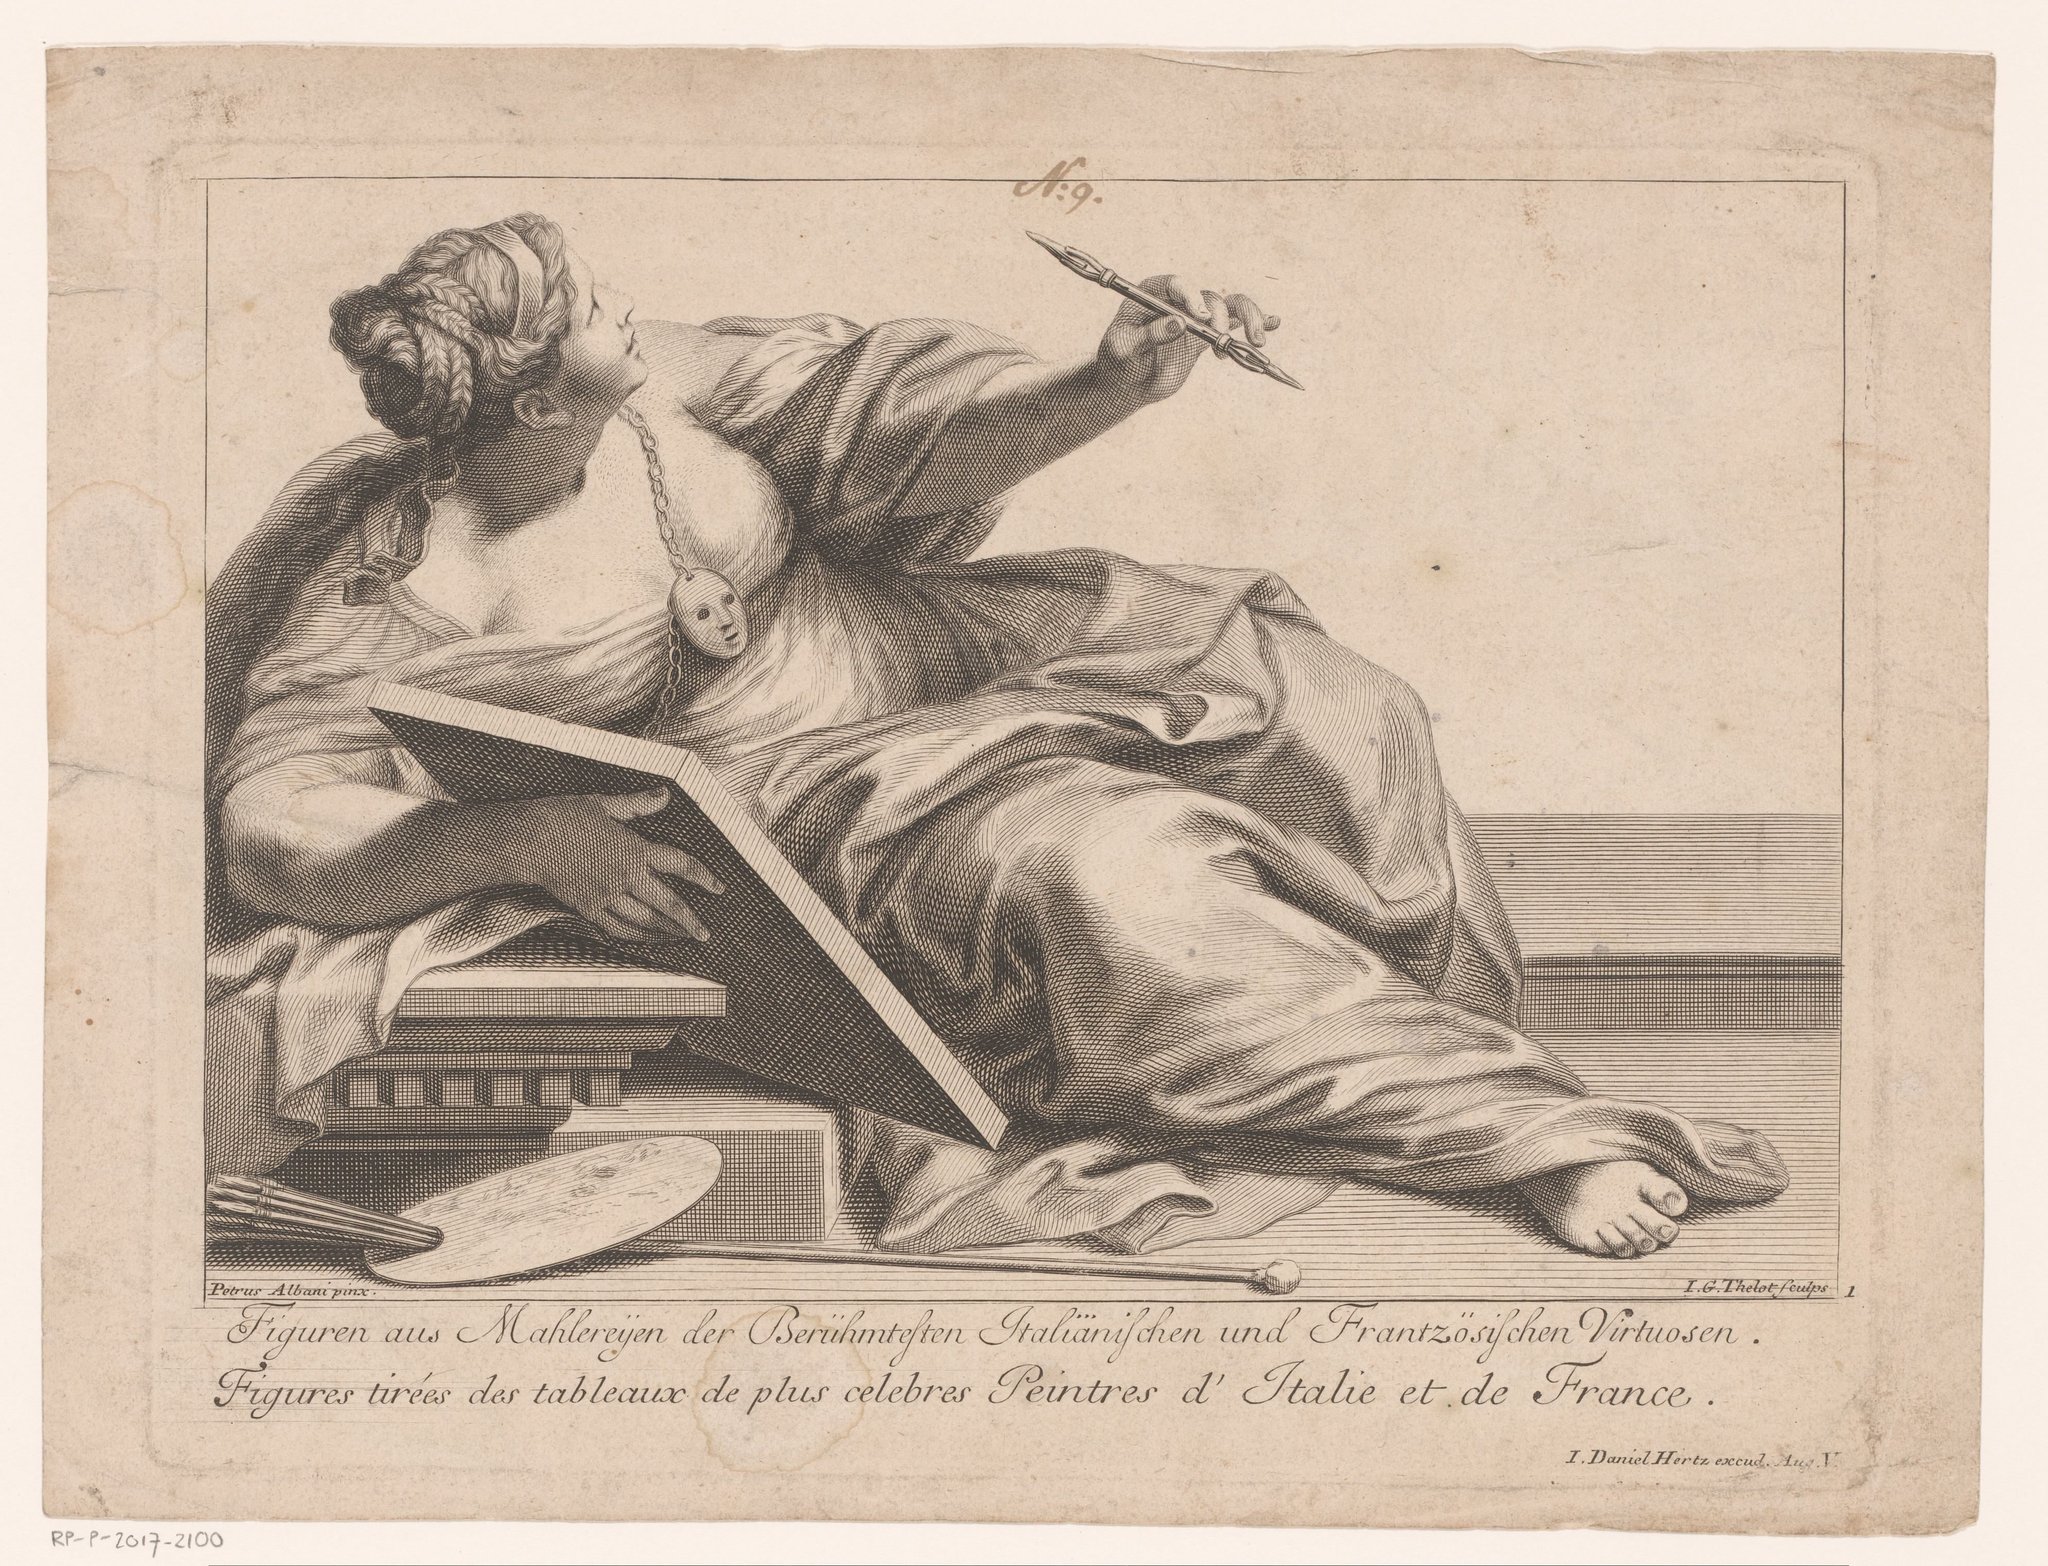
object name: print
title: Personificatie van de schilderkunst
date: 1718-1775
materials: paper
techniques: engraving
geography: augsburg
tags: 'pictura', symbolic representations, allegories and emblems ~ painting; 'pittura' (ripa), tools, implements of painter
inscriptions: number: ‘N: 9.’, collector's mark: Lugt 240